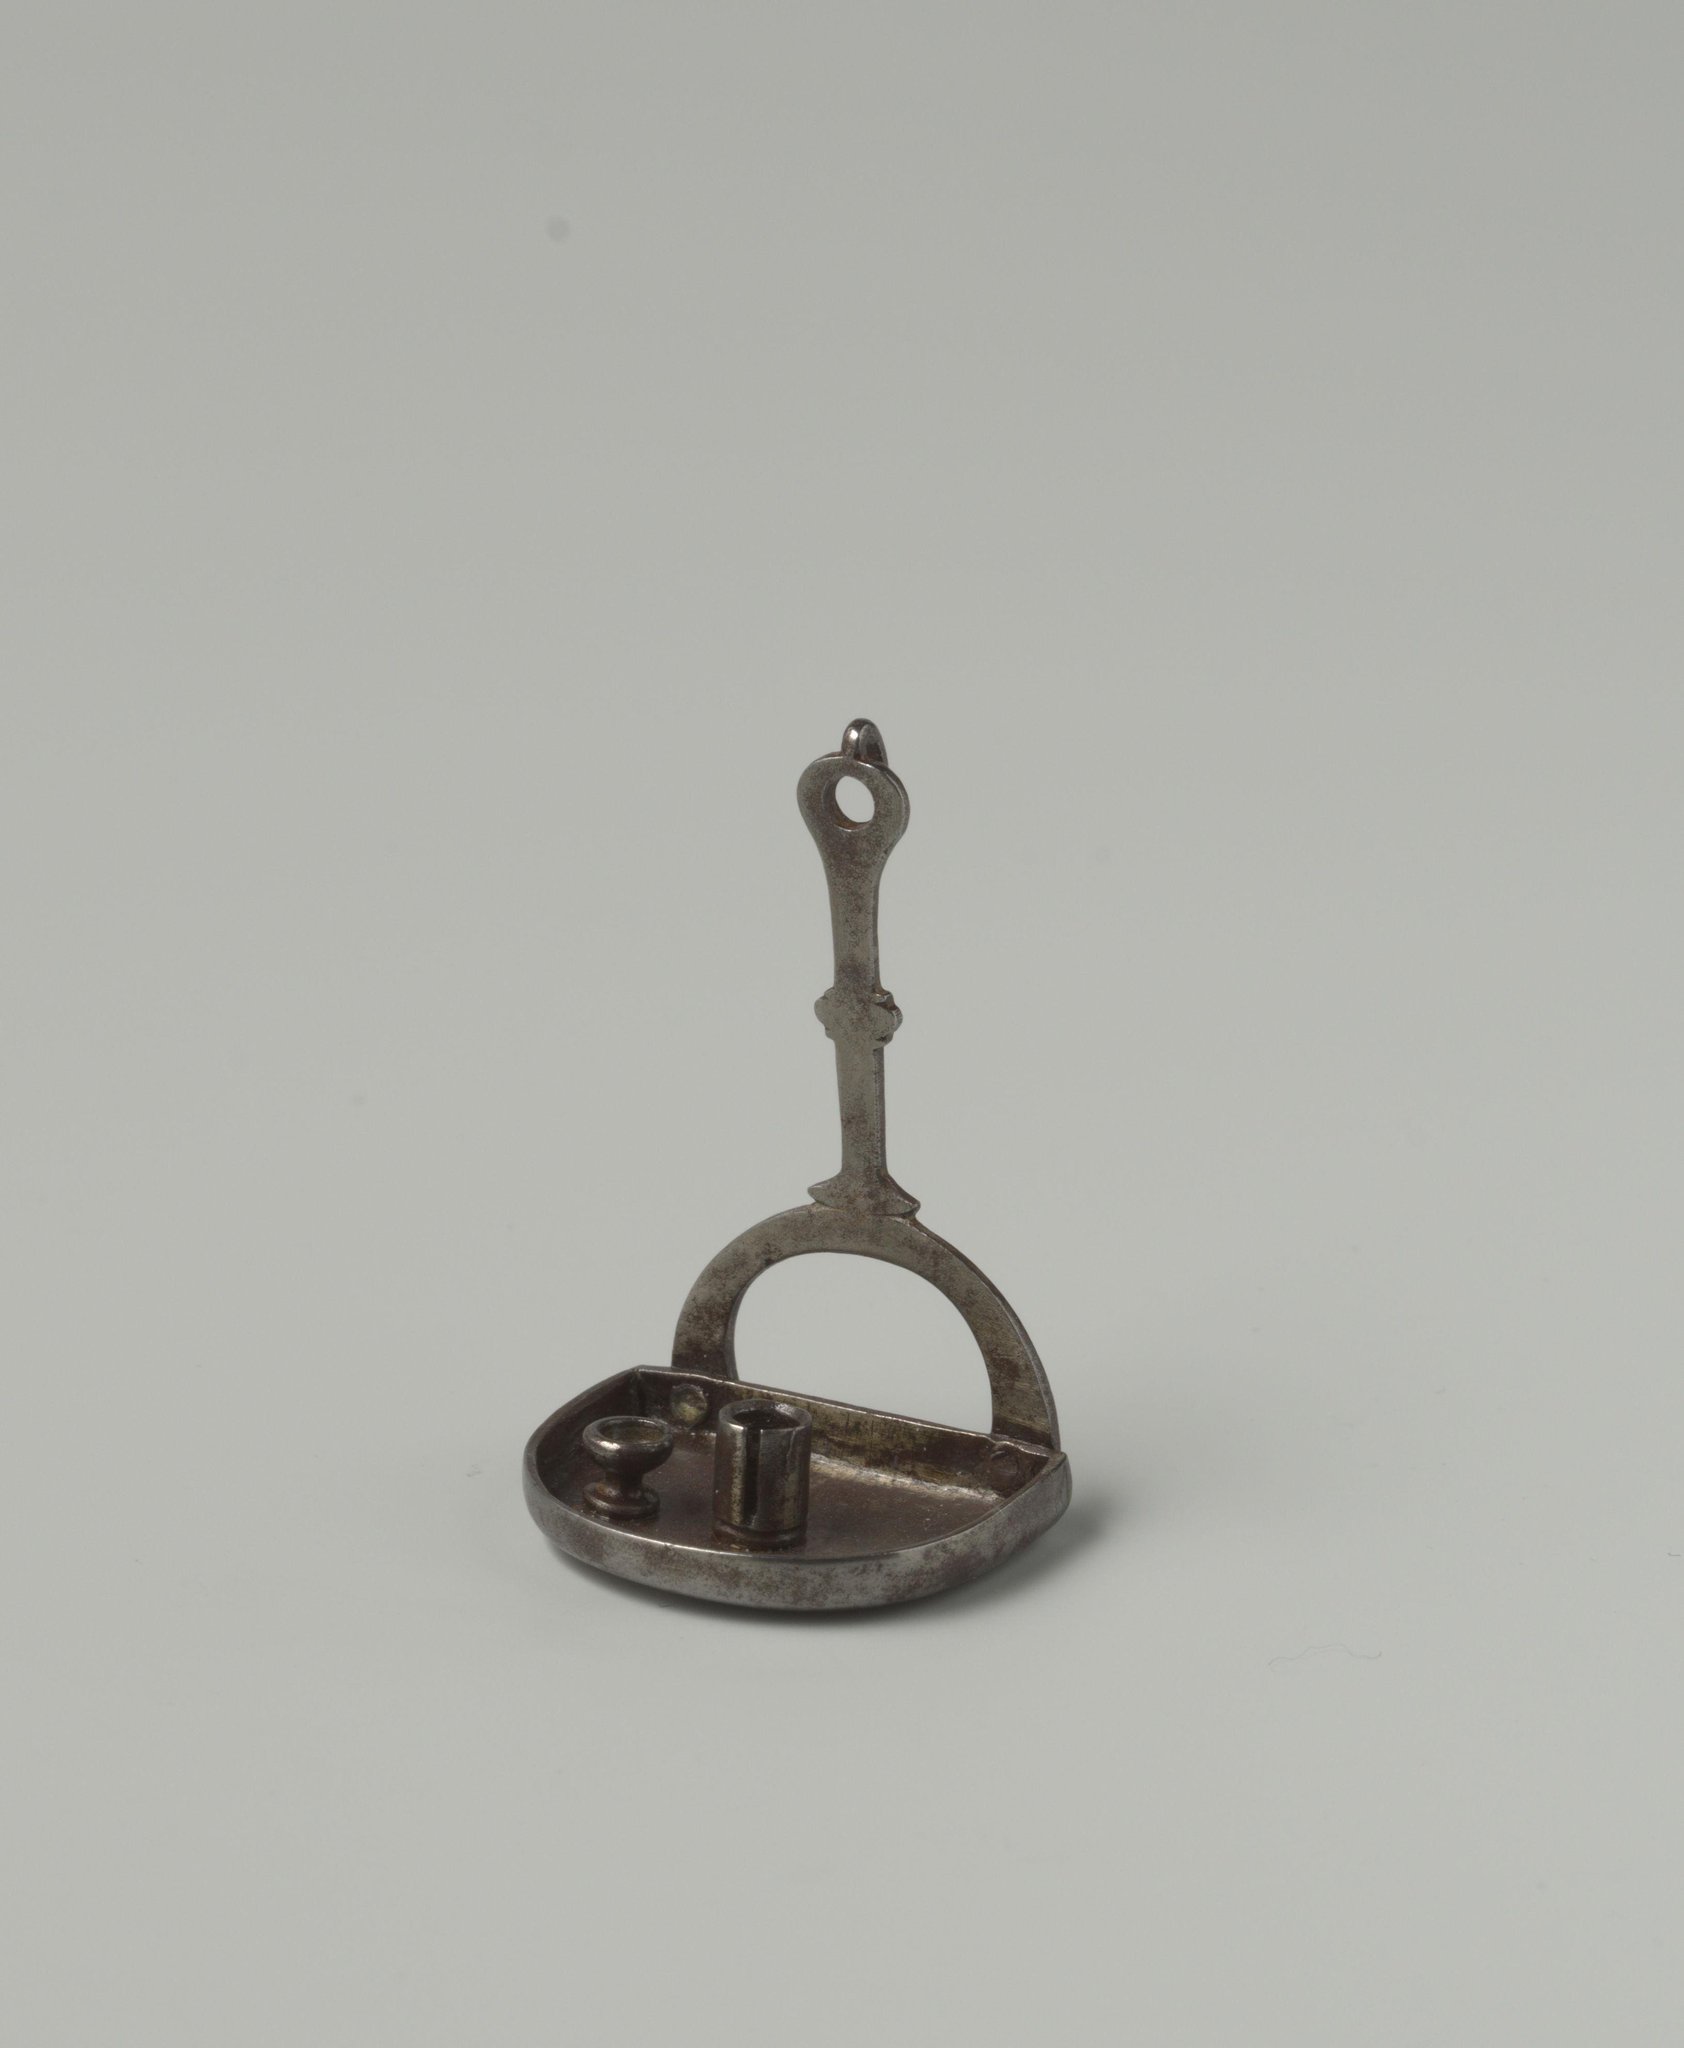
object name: miniature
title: Wandblaker van smeedijzer, bestaande uit een bodem met opstaande rand, waarop een kaarshouder en een klein bakje op voet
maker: Anonymous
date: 1690-1710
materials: iron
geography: amsterdam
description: Wandblaker vervaardigd van smeedijzer, bestaande uit een bodem met opstaande rand, waarop een kaarsehouder en een klein bakje op voet ('profijtertje' voor het opbranden van het laatste stompje kaars?); aan de rechter achterzijde is een open steelvormige wandplaat vastgeklonken met haakje en oogje aan bovenkant.